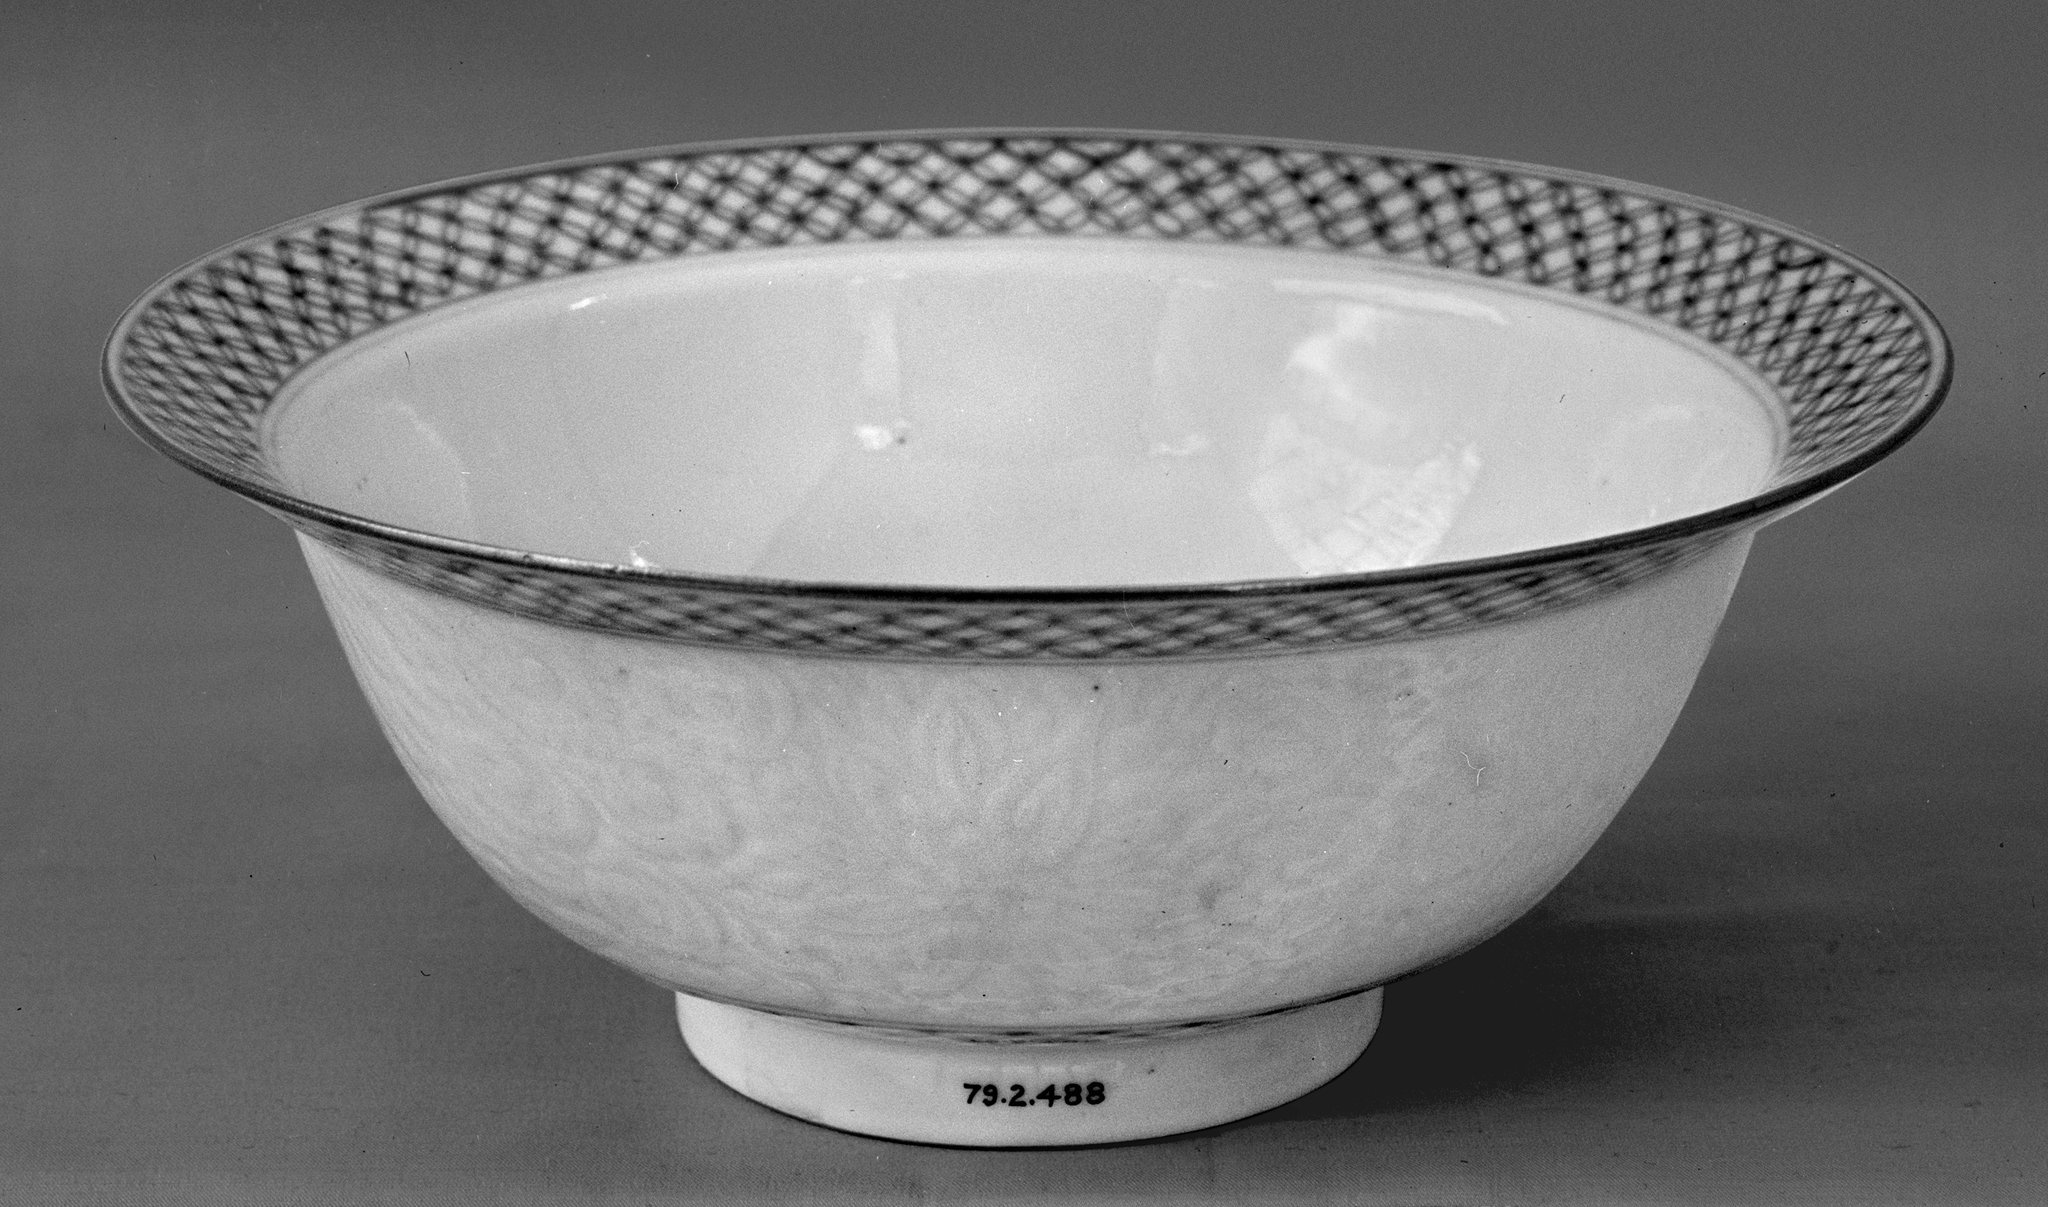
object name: bowl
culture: chinese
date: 1701-1800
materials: cobalt, porcelain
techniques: painting, relief, underglaze